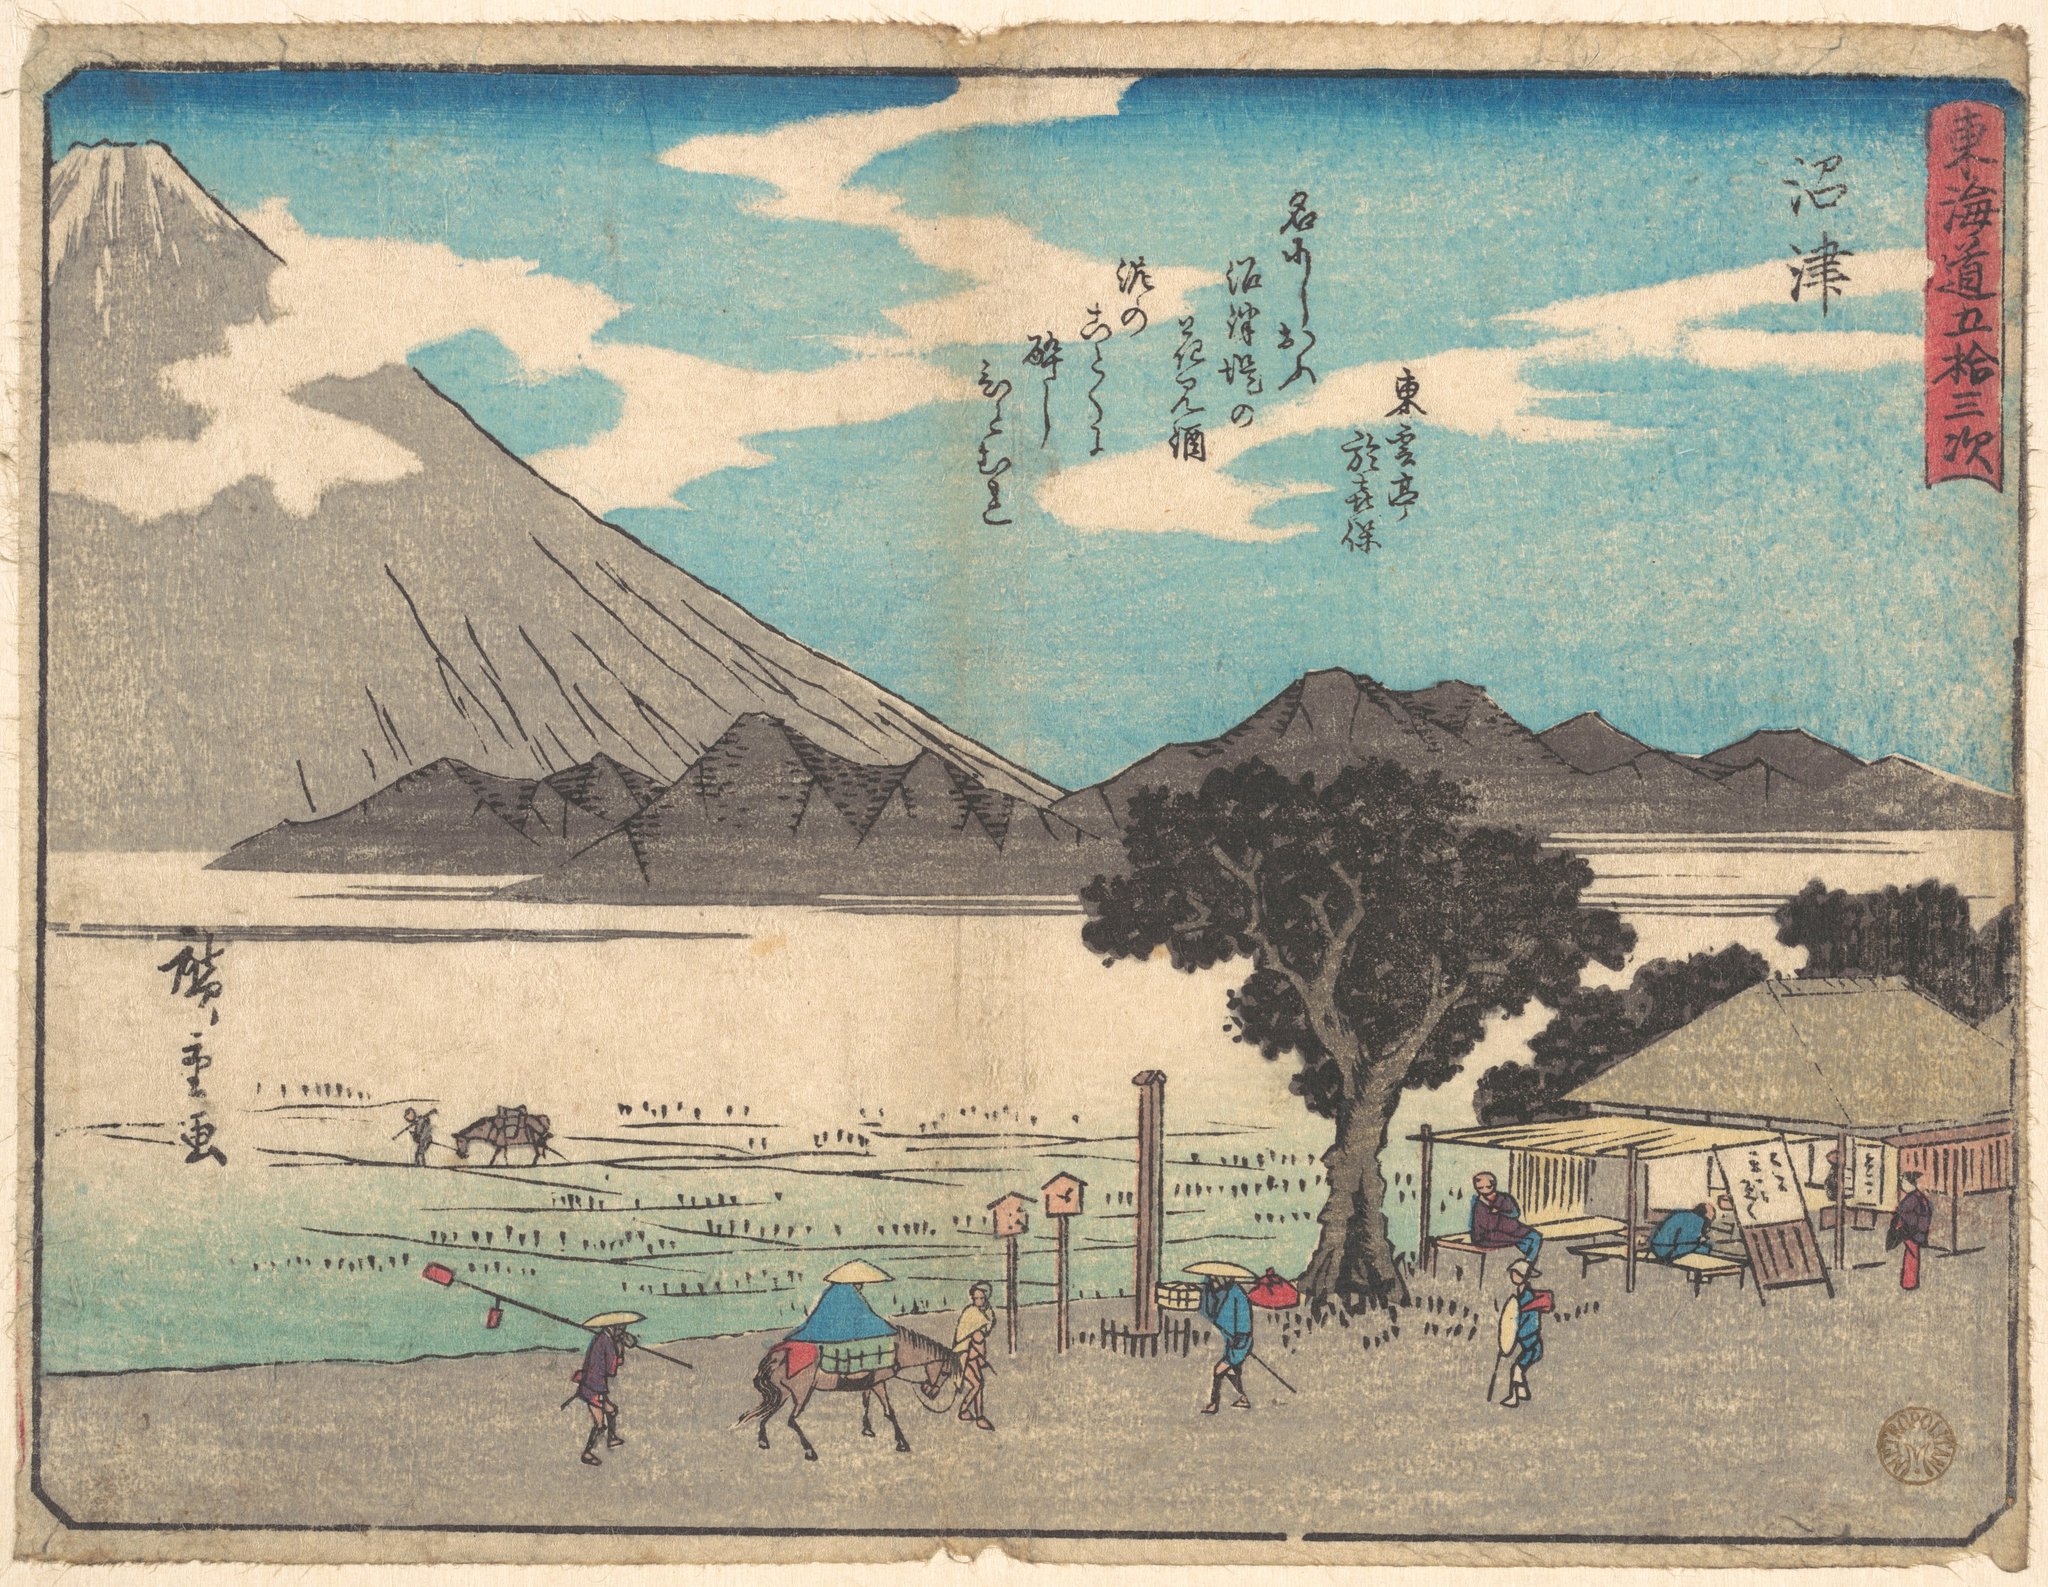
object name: print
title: Numazu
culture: japanese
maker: utagawa hiroshige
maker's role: artist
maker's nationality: japanese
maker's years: 1797-1858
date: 1838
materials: ink, paper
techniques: woodblock print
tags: human figures,houses,mountains,trees